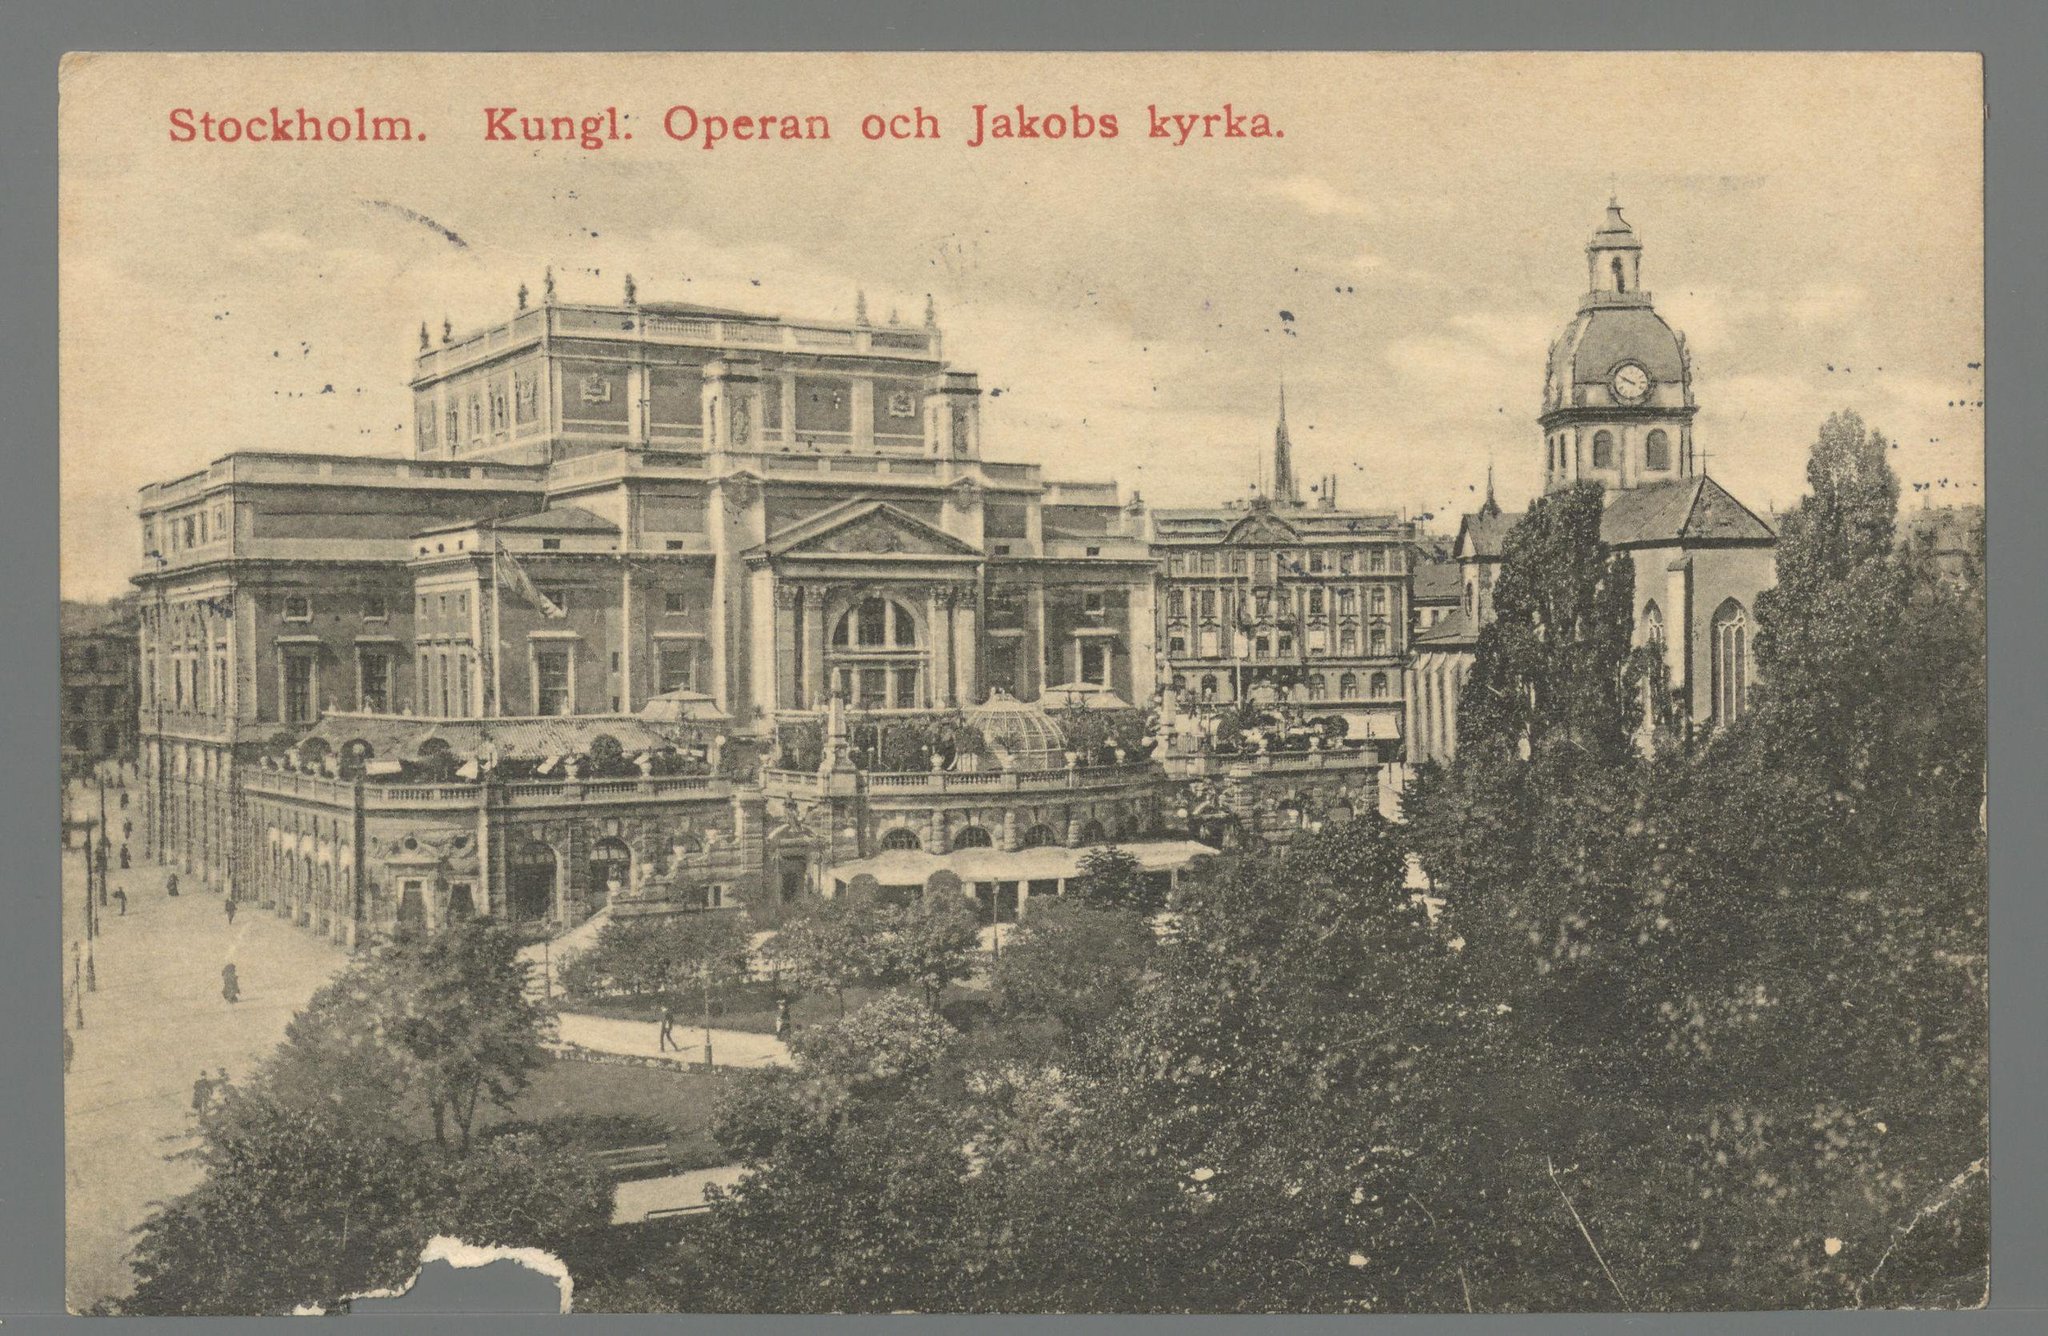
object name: ansichtkaart, prentbriefkaart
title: Stockholm. Kungl. Operan och Jakobs kyrka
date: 1905-1910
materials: cardboard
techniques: photograph, writing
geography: stockholm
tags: church (exterior), opera house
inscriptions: inscription: ‘C. N:s Lj.’